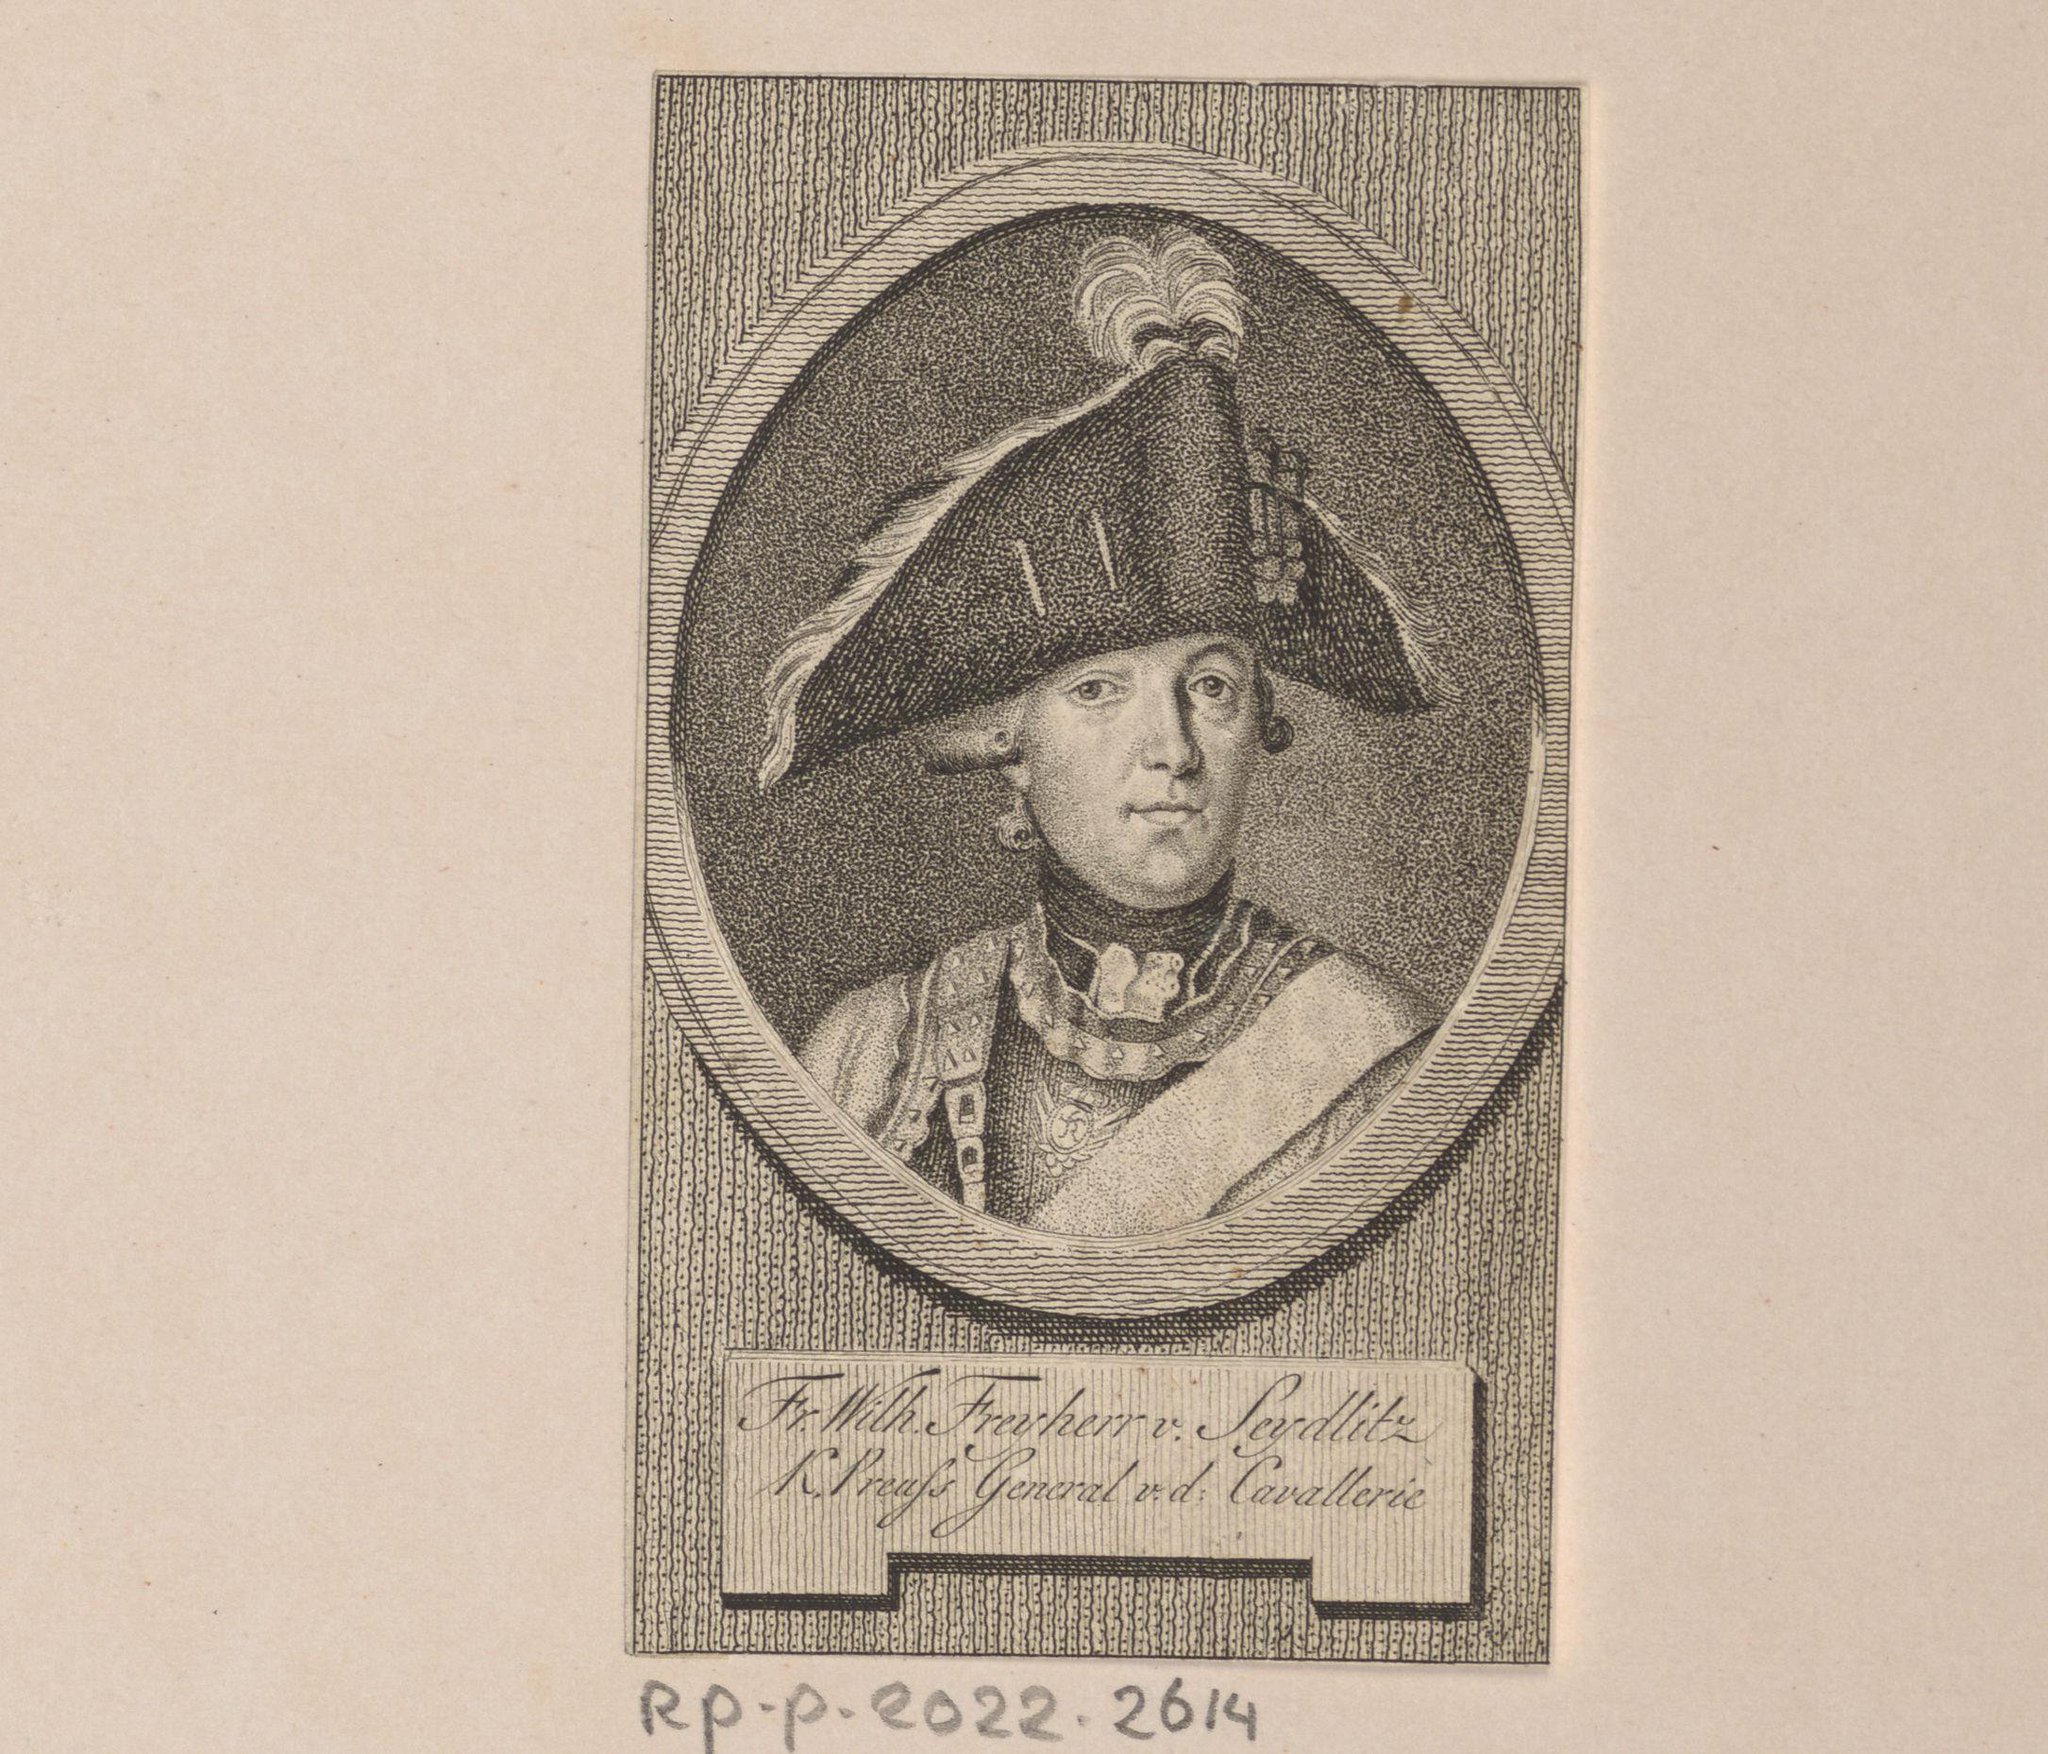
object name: print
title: Portret van Friedrich Wilhelm von Seydlitz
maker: eberhard siegfried henne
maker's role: print maker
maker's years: 1759-1828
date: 1769-1828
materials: paper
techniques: etching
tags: kalkar, commander-in-chief, general, marshal, historical persons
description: Met eenregelig onderschrift in het Duits.